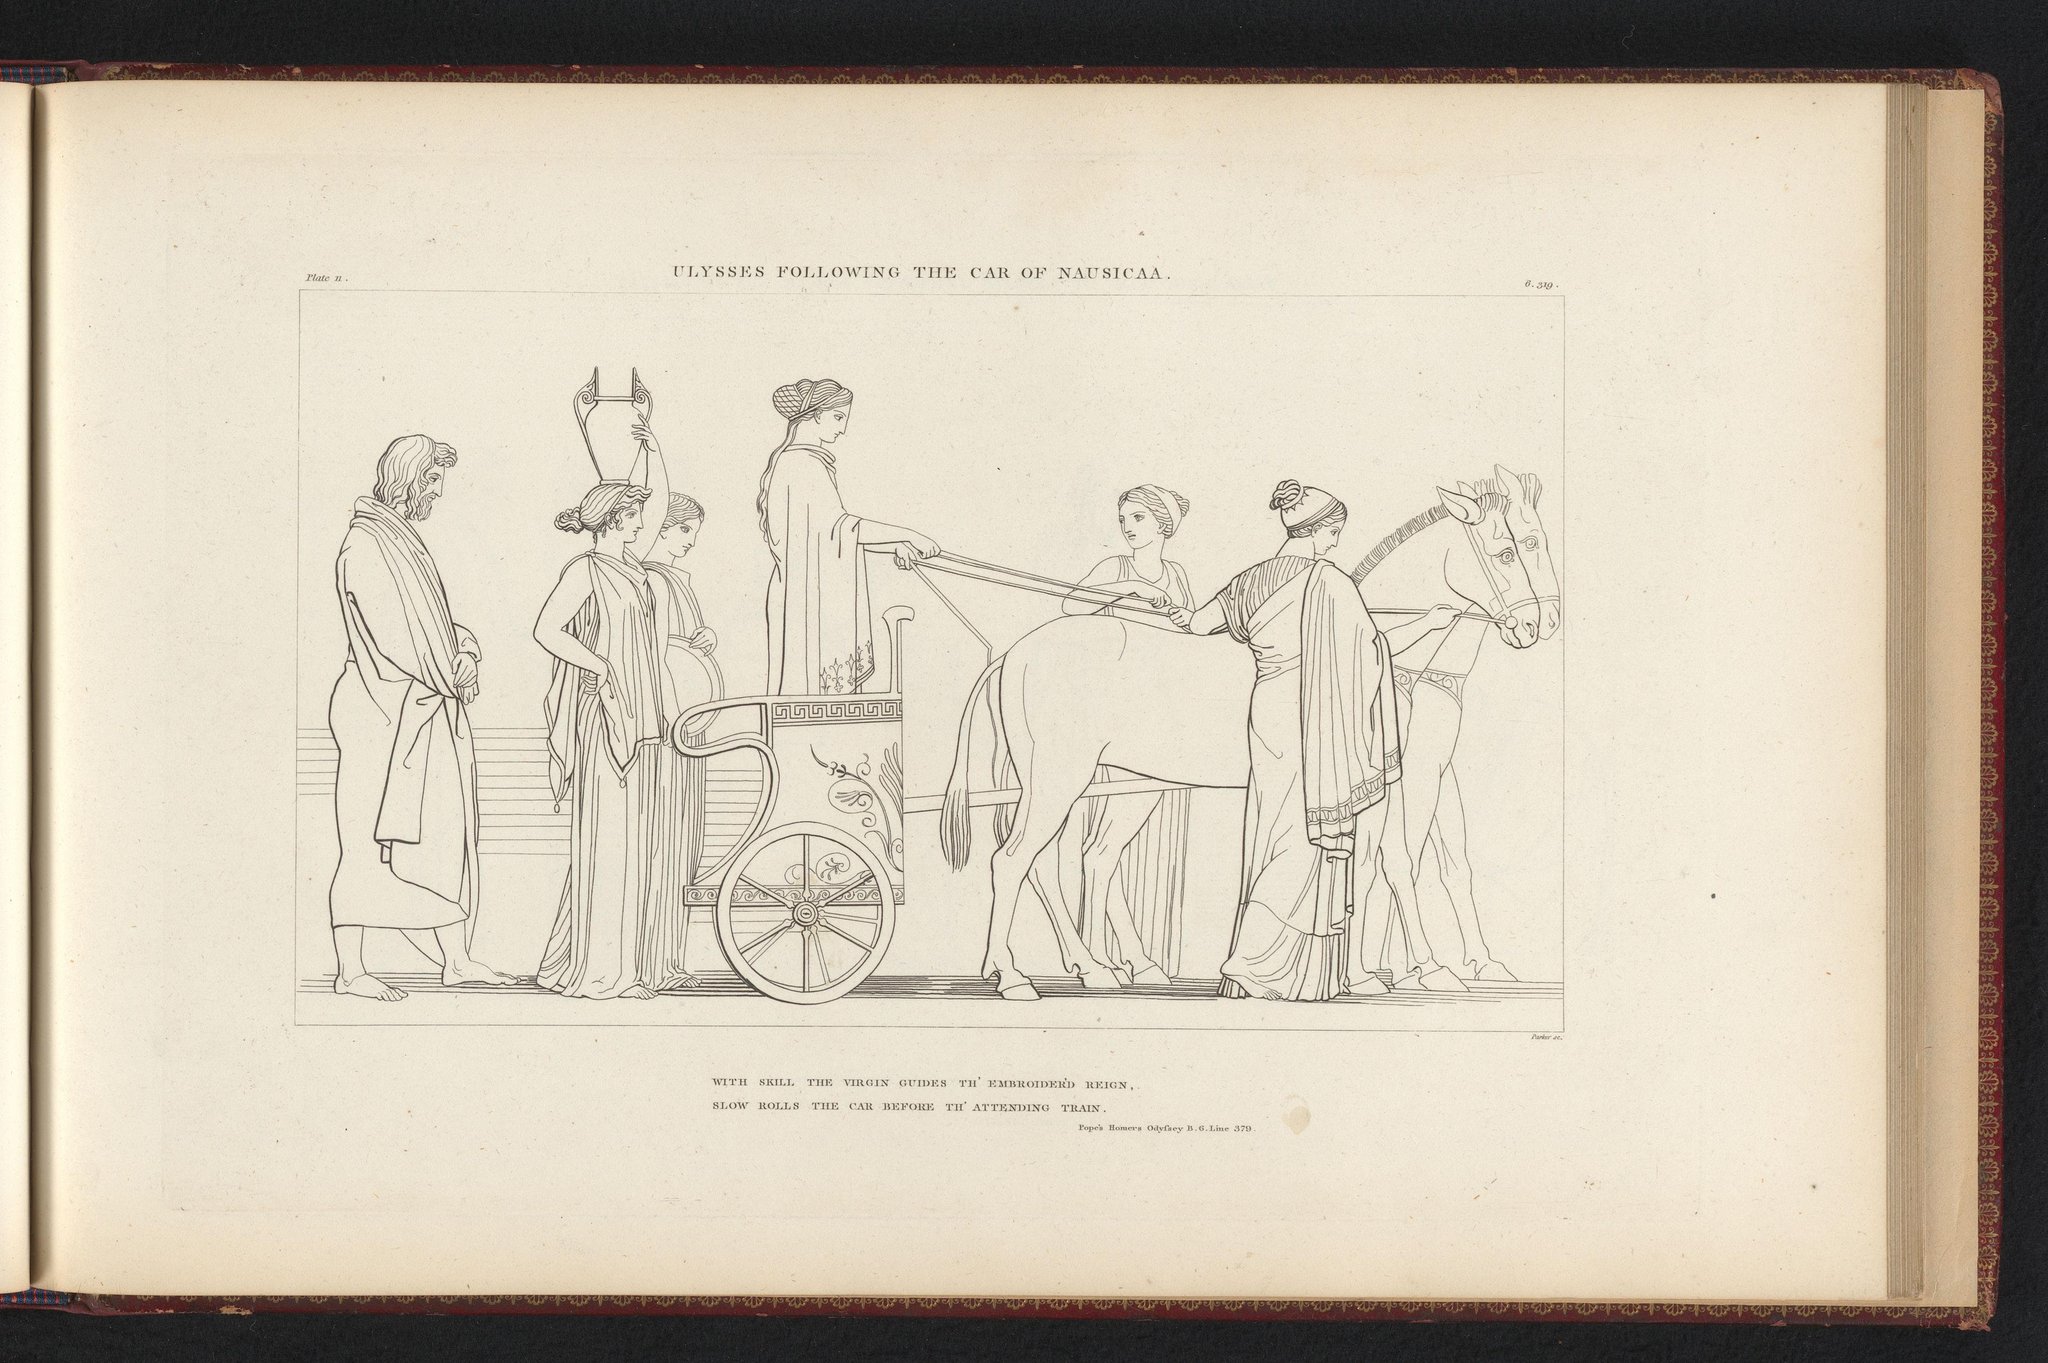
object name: album leaf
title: Odyssee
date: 1805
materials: paper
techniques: etching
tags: ulysses at alcinous' court, meeting of nausicaa and ulysses: ulysses, almost naked, comes out of the bushes; nausicaa and her companions are startled at the sight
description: Prent maakt onderdeel uit van een serie met 34 prenten over de Odyssee, geschreven door Homerus.